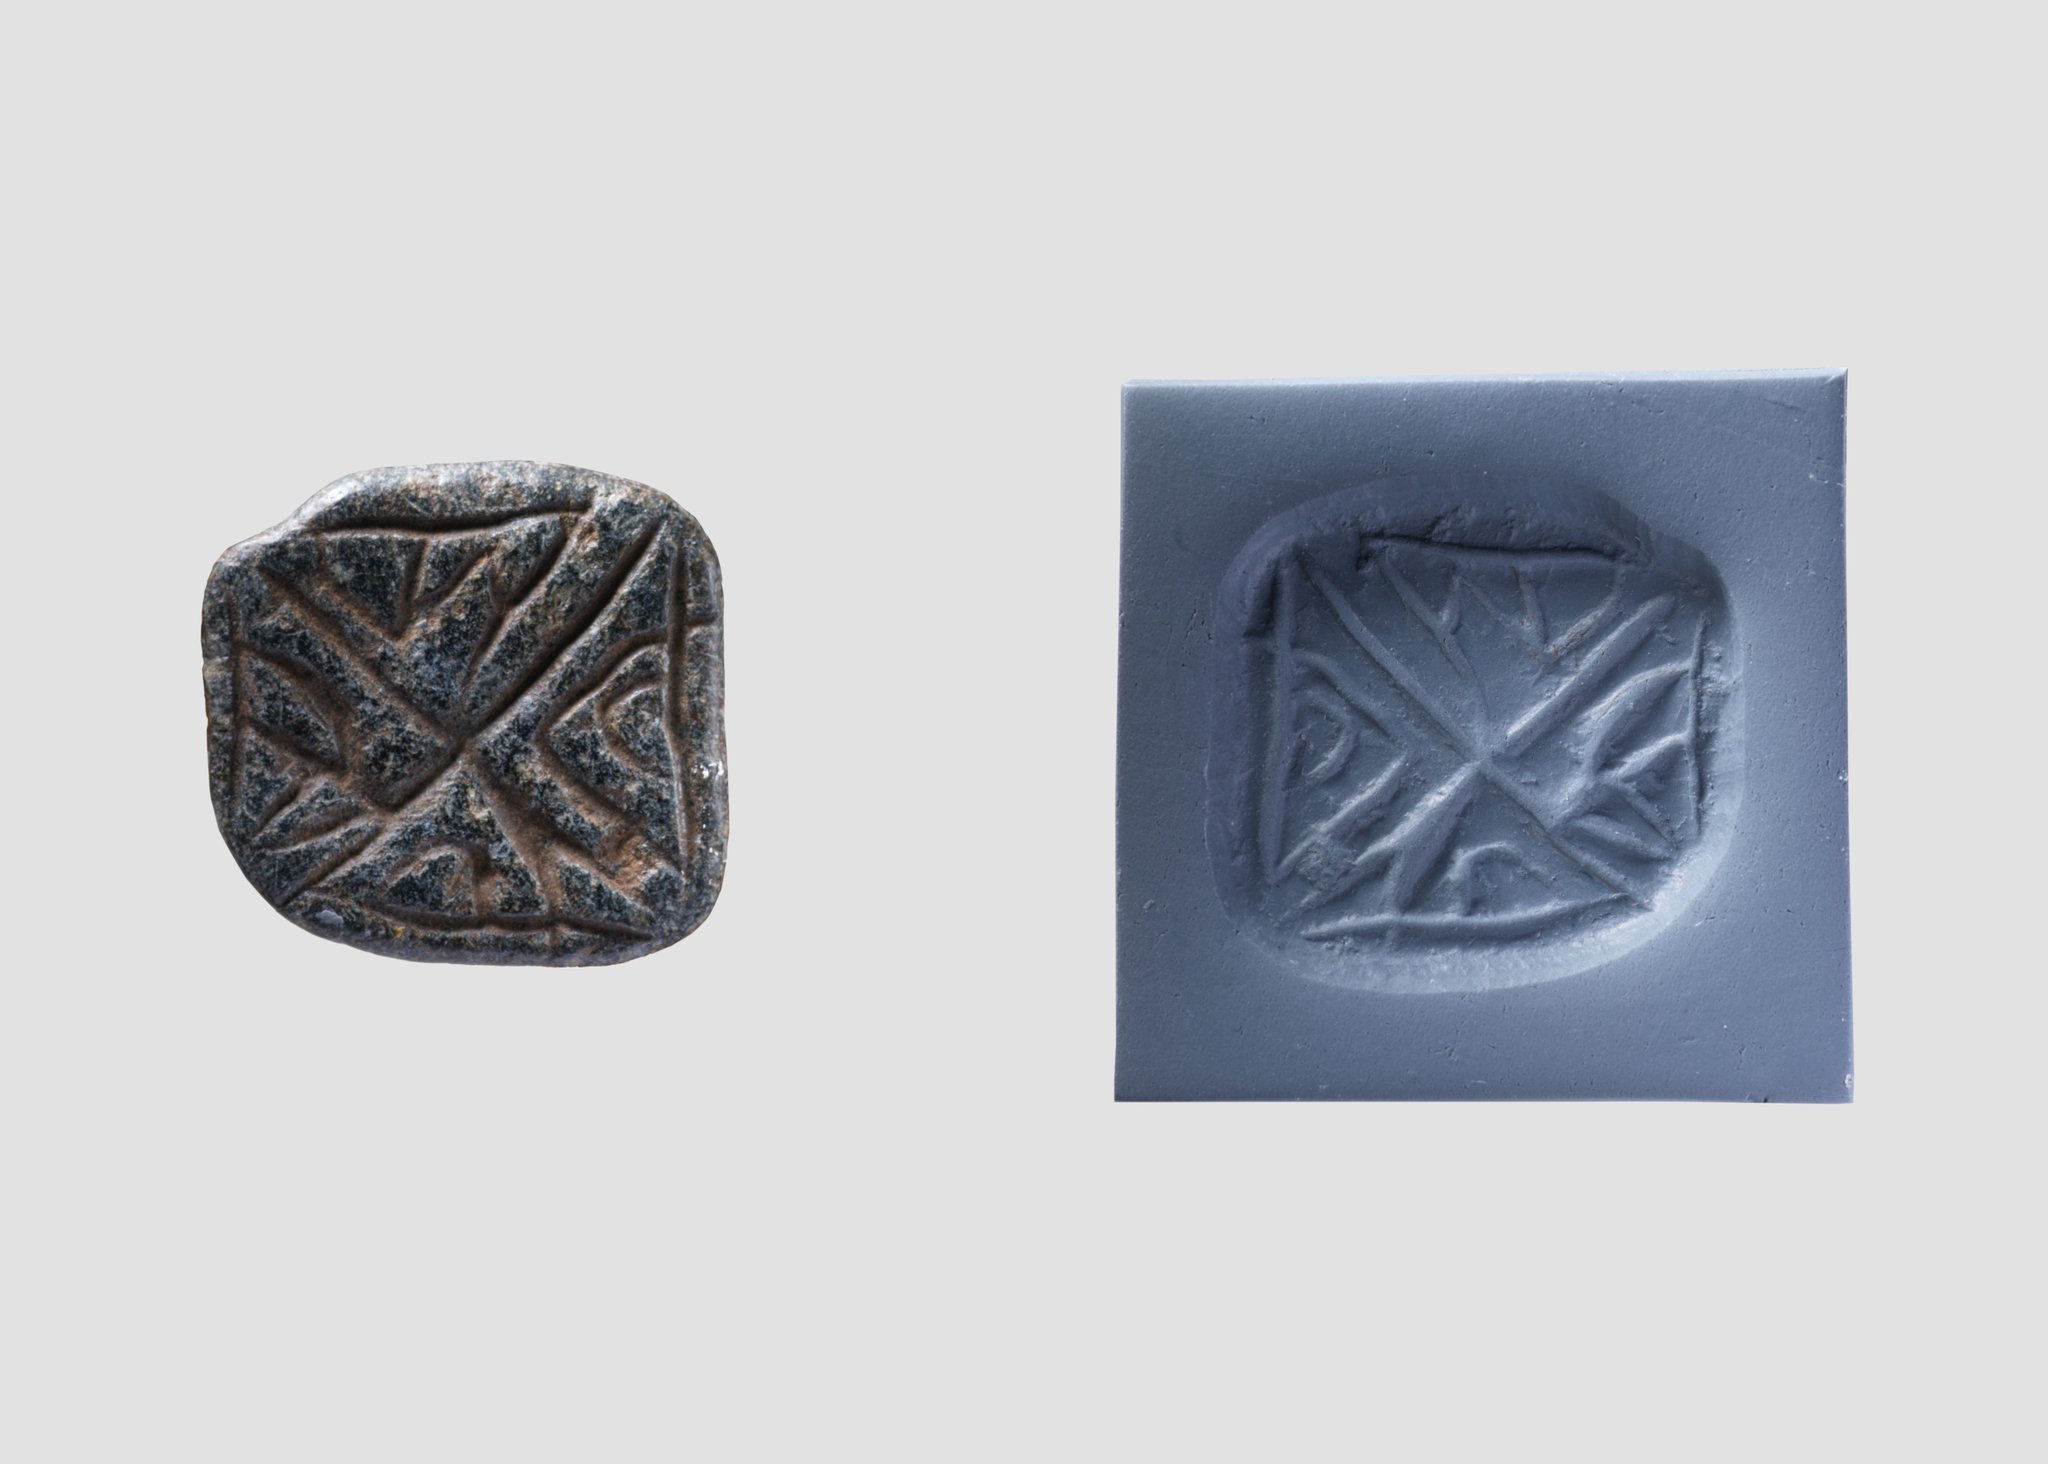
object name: stamp seal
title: Conoid seal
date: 5000-3001 BCE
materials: mineral, stone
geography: northern syria (?)